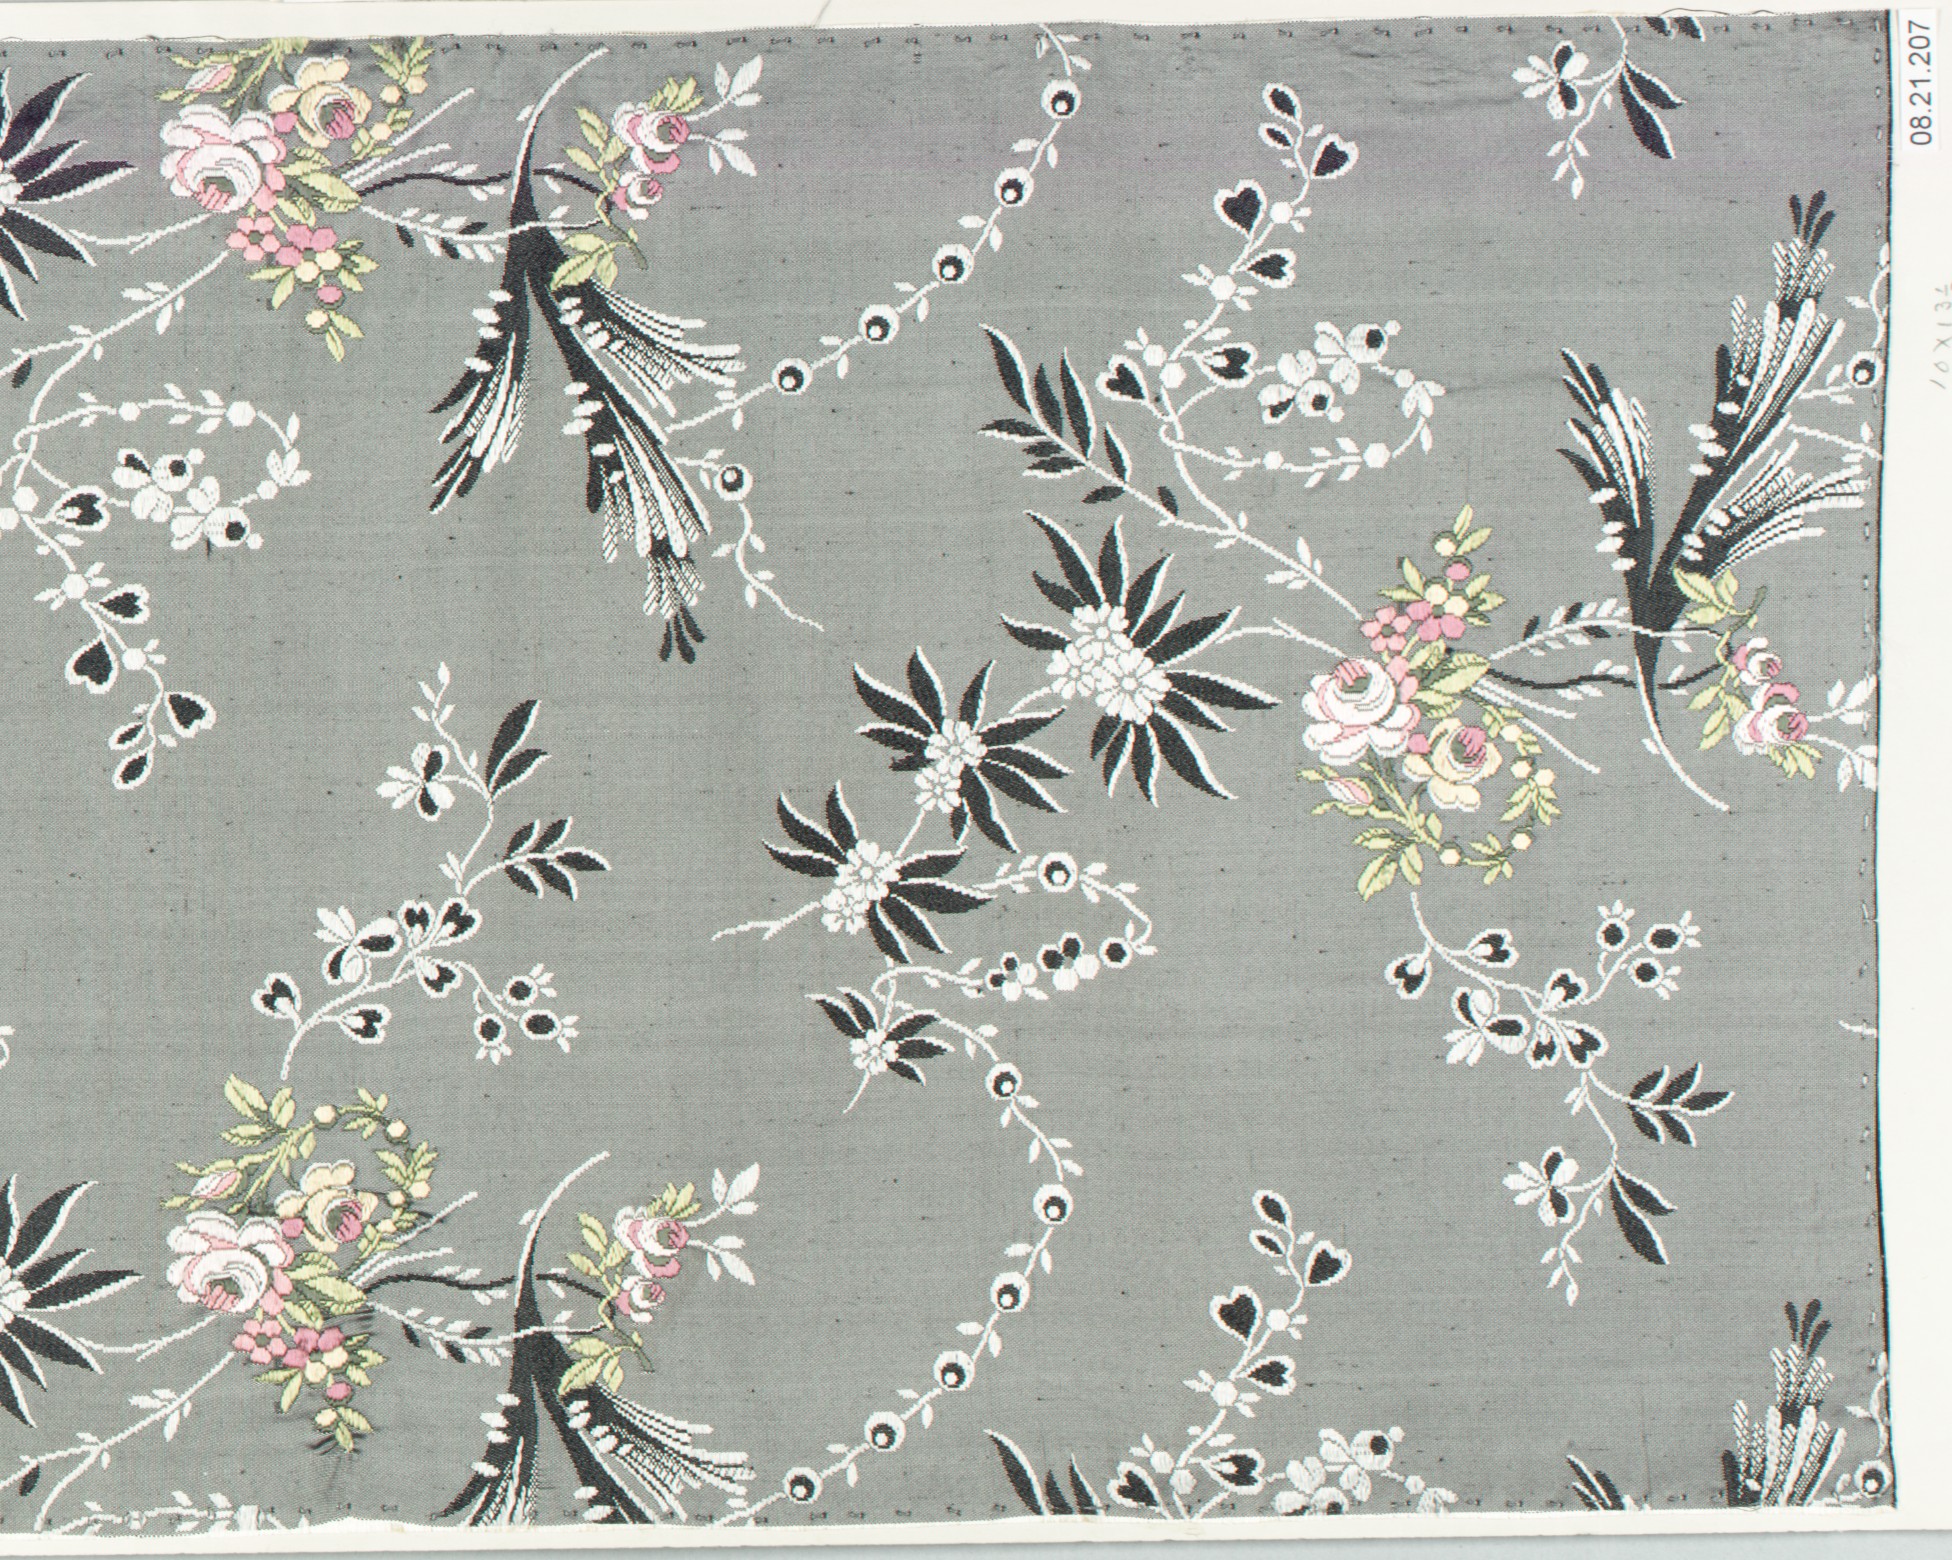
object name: textile sample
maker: Anonymous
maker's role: designer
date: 1900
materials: silk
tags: flowers